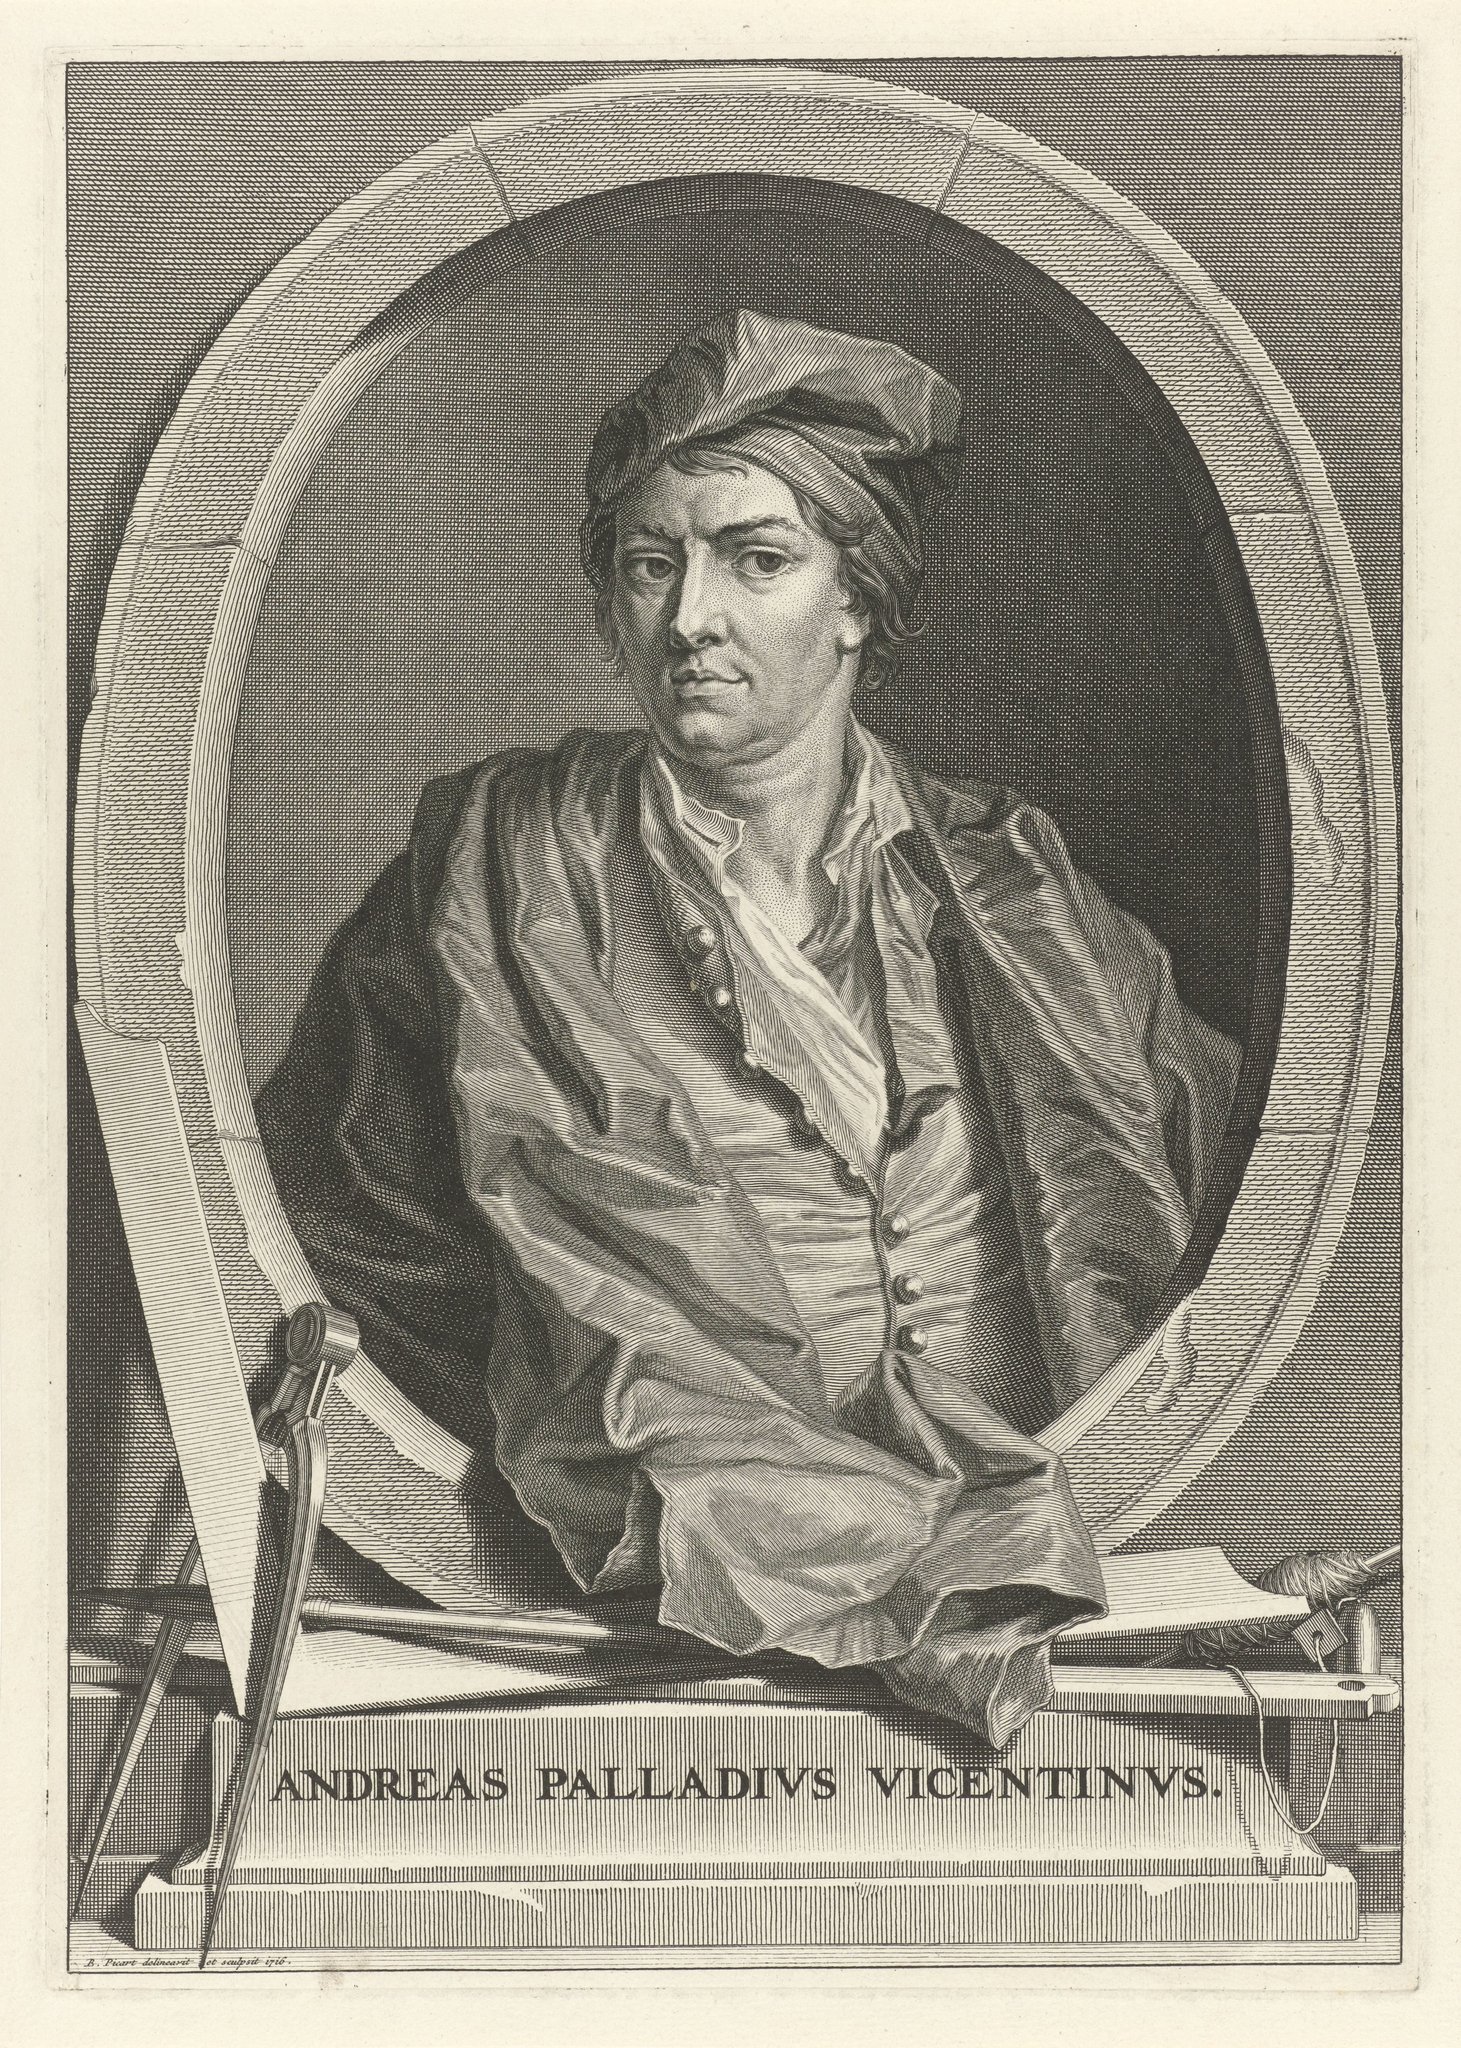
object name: print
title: Portret van Andrea Palladio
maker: bernard picart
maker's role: draughtsman, print maker, publisher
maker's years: 1673-1733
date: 1716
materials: paper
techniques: engraving, etching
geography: amsterdam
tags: andrea palladio, portrait, self-portrait of architect, portrait, self-portrait of artist, tools, implements of architect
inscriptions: collector's mark: Lugt 240, inscription: ‘d l : s’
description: Portret van de Italiaanse architect Andrea di Pietro della Gondola (Palladio). Op de piëdestal diverse attributen waaronder een passer.